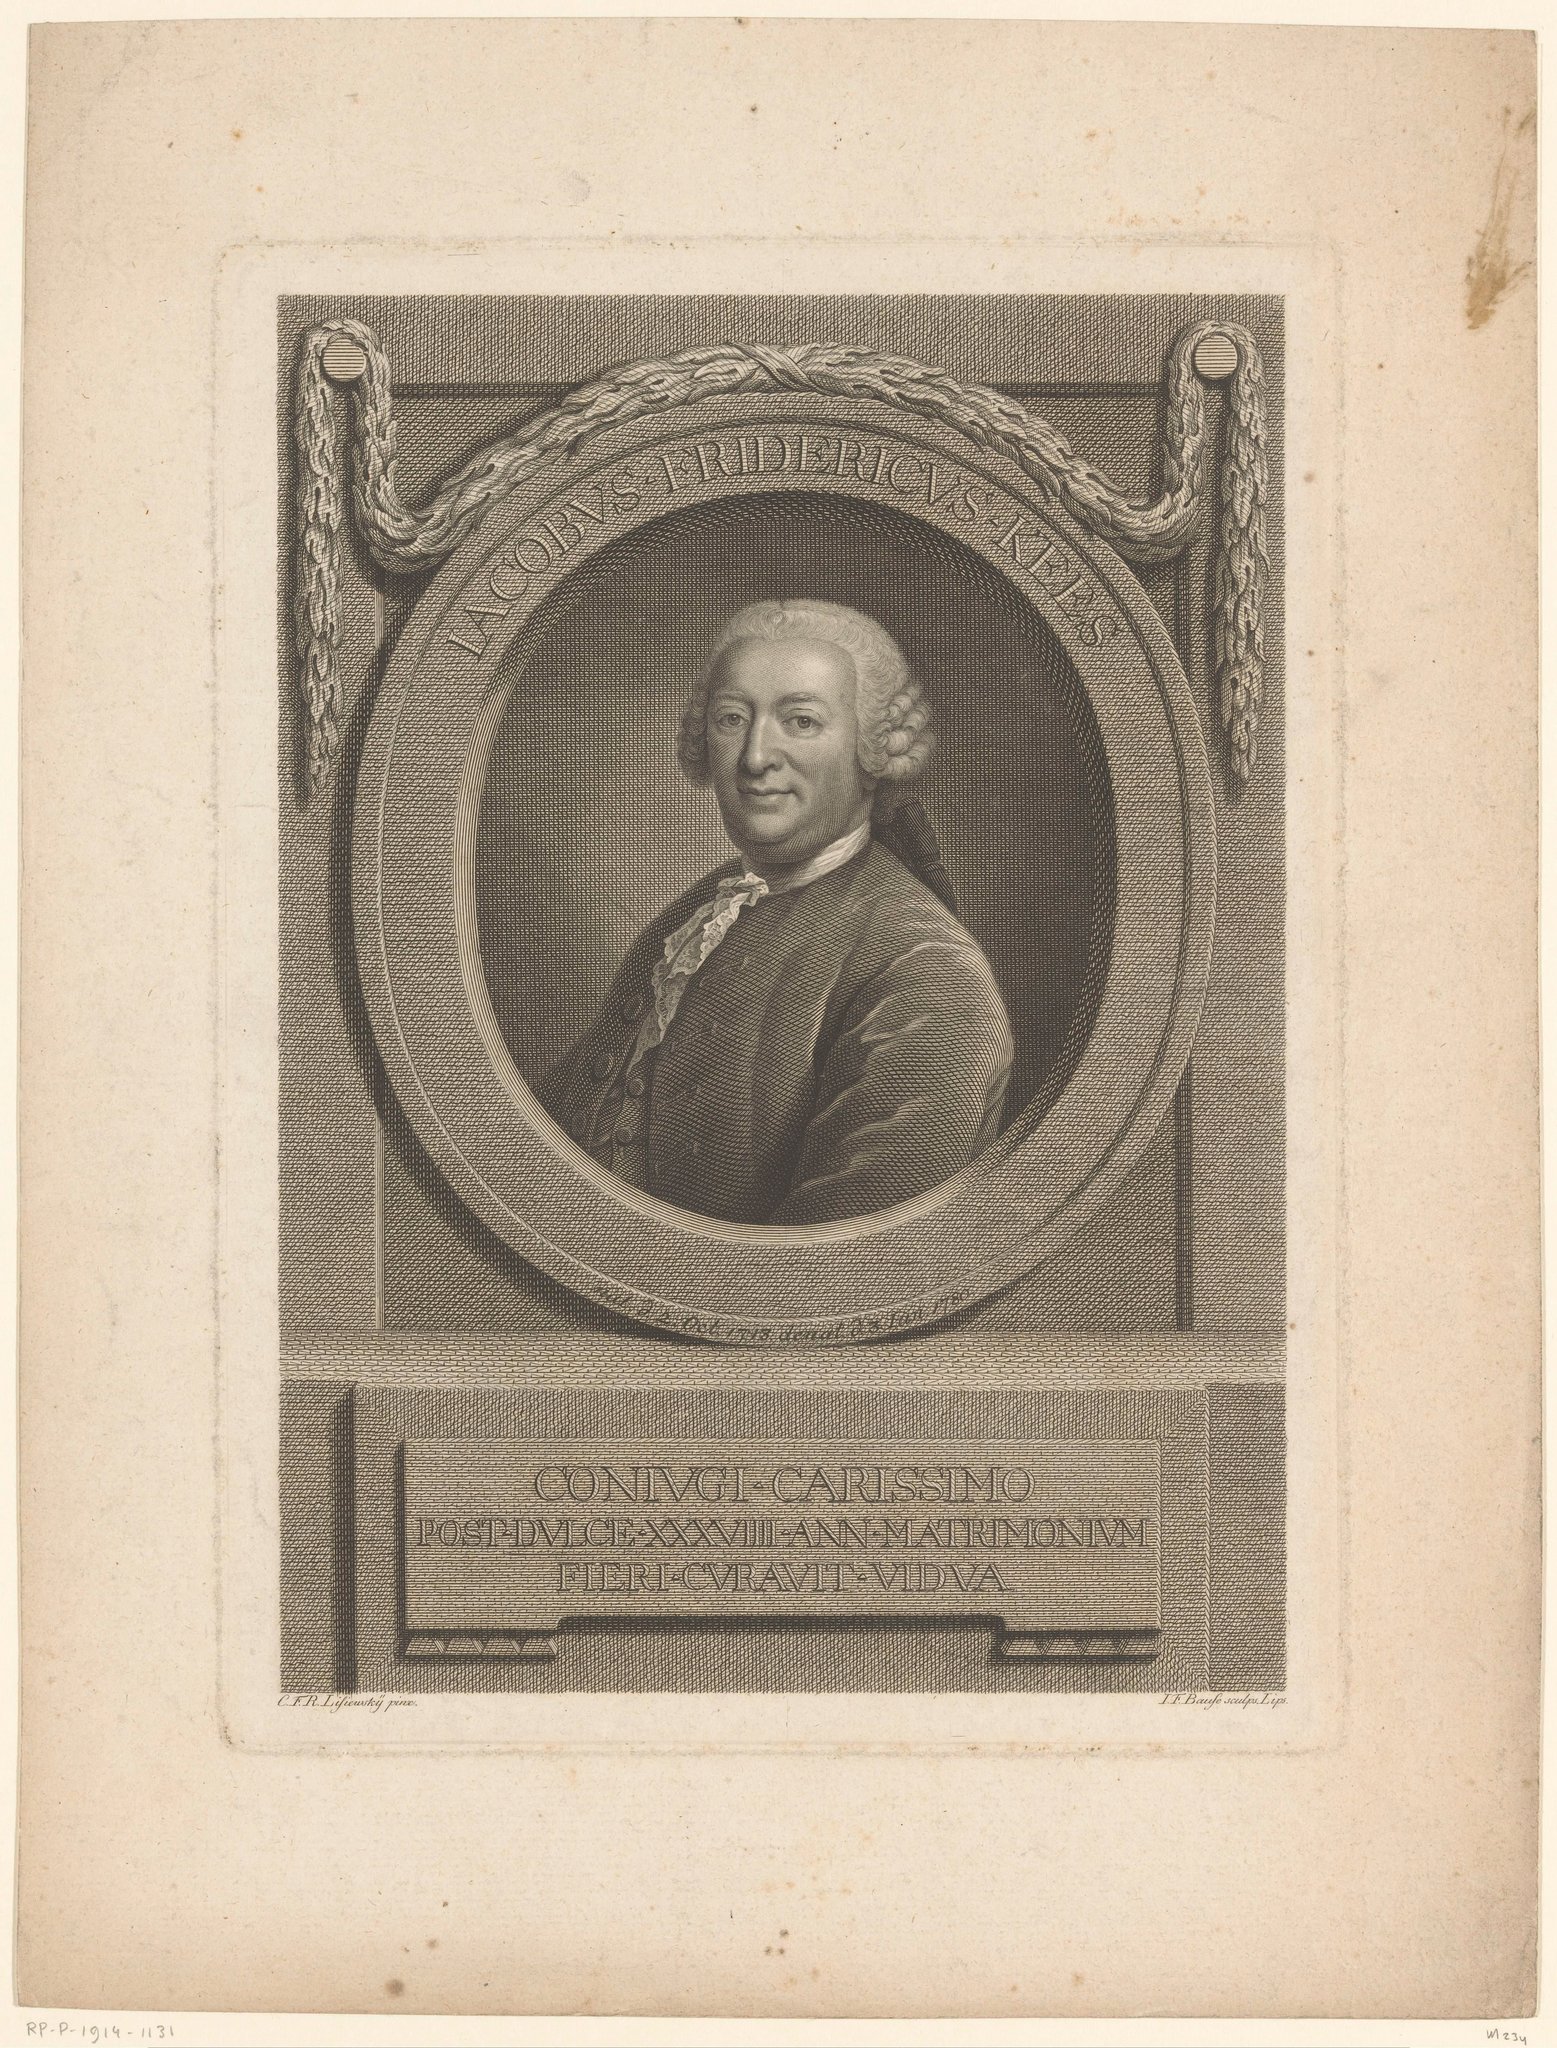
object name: print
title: Portret van Jacob Friedrich Kees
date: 1781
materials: paper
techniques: engraving, etching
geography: leipzig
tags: historical persons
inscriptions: collector's mark: Lugt 2228